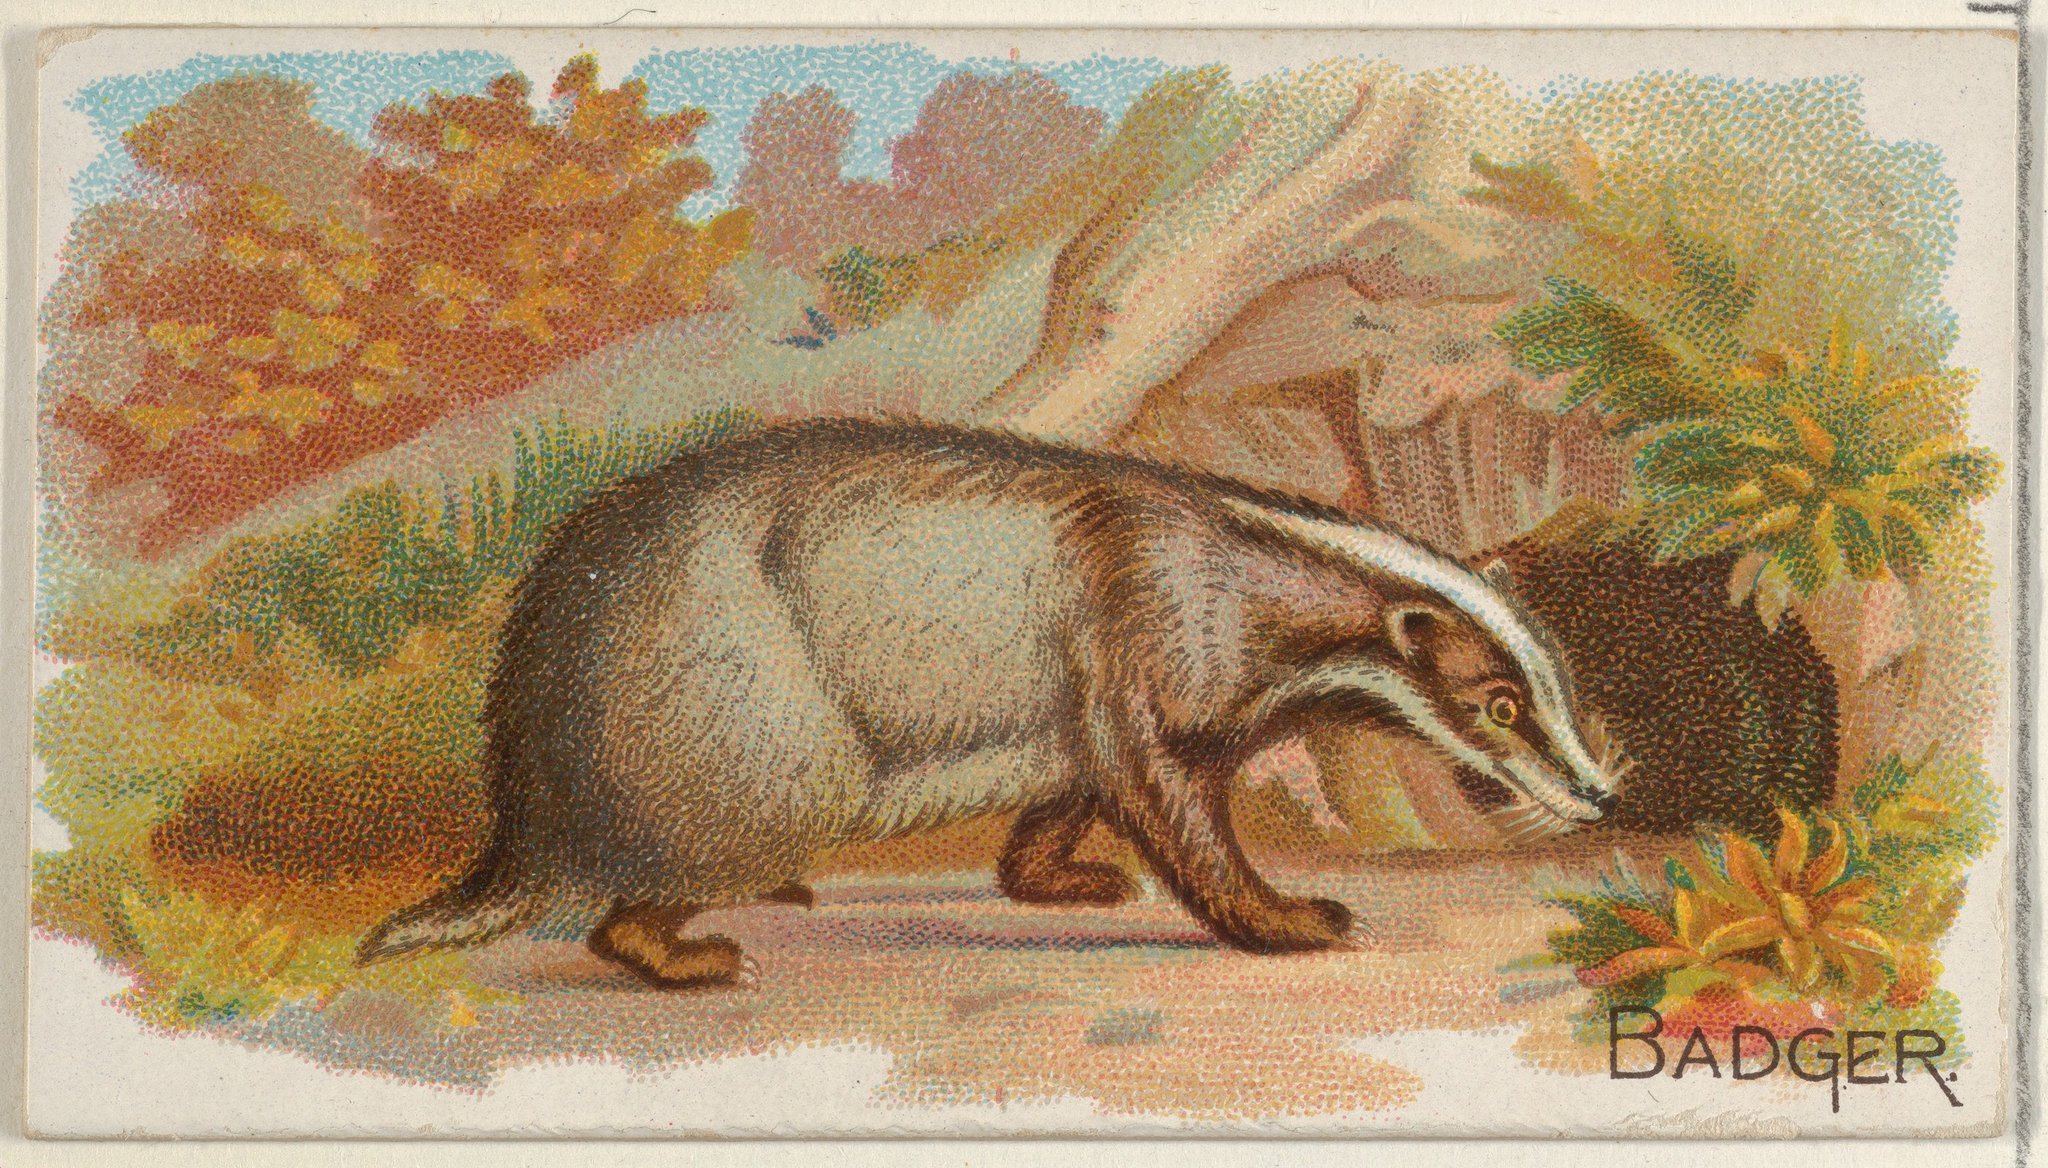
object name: print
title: Badger, from the Quadrupeds series (N21) for Allen & Ginter Cigarettes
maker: allen & ginter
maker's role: publisher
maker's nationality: american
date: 1890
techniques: color lithograph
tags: animals